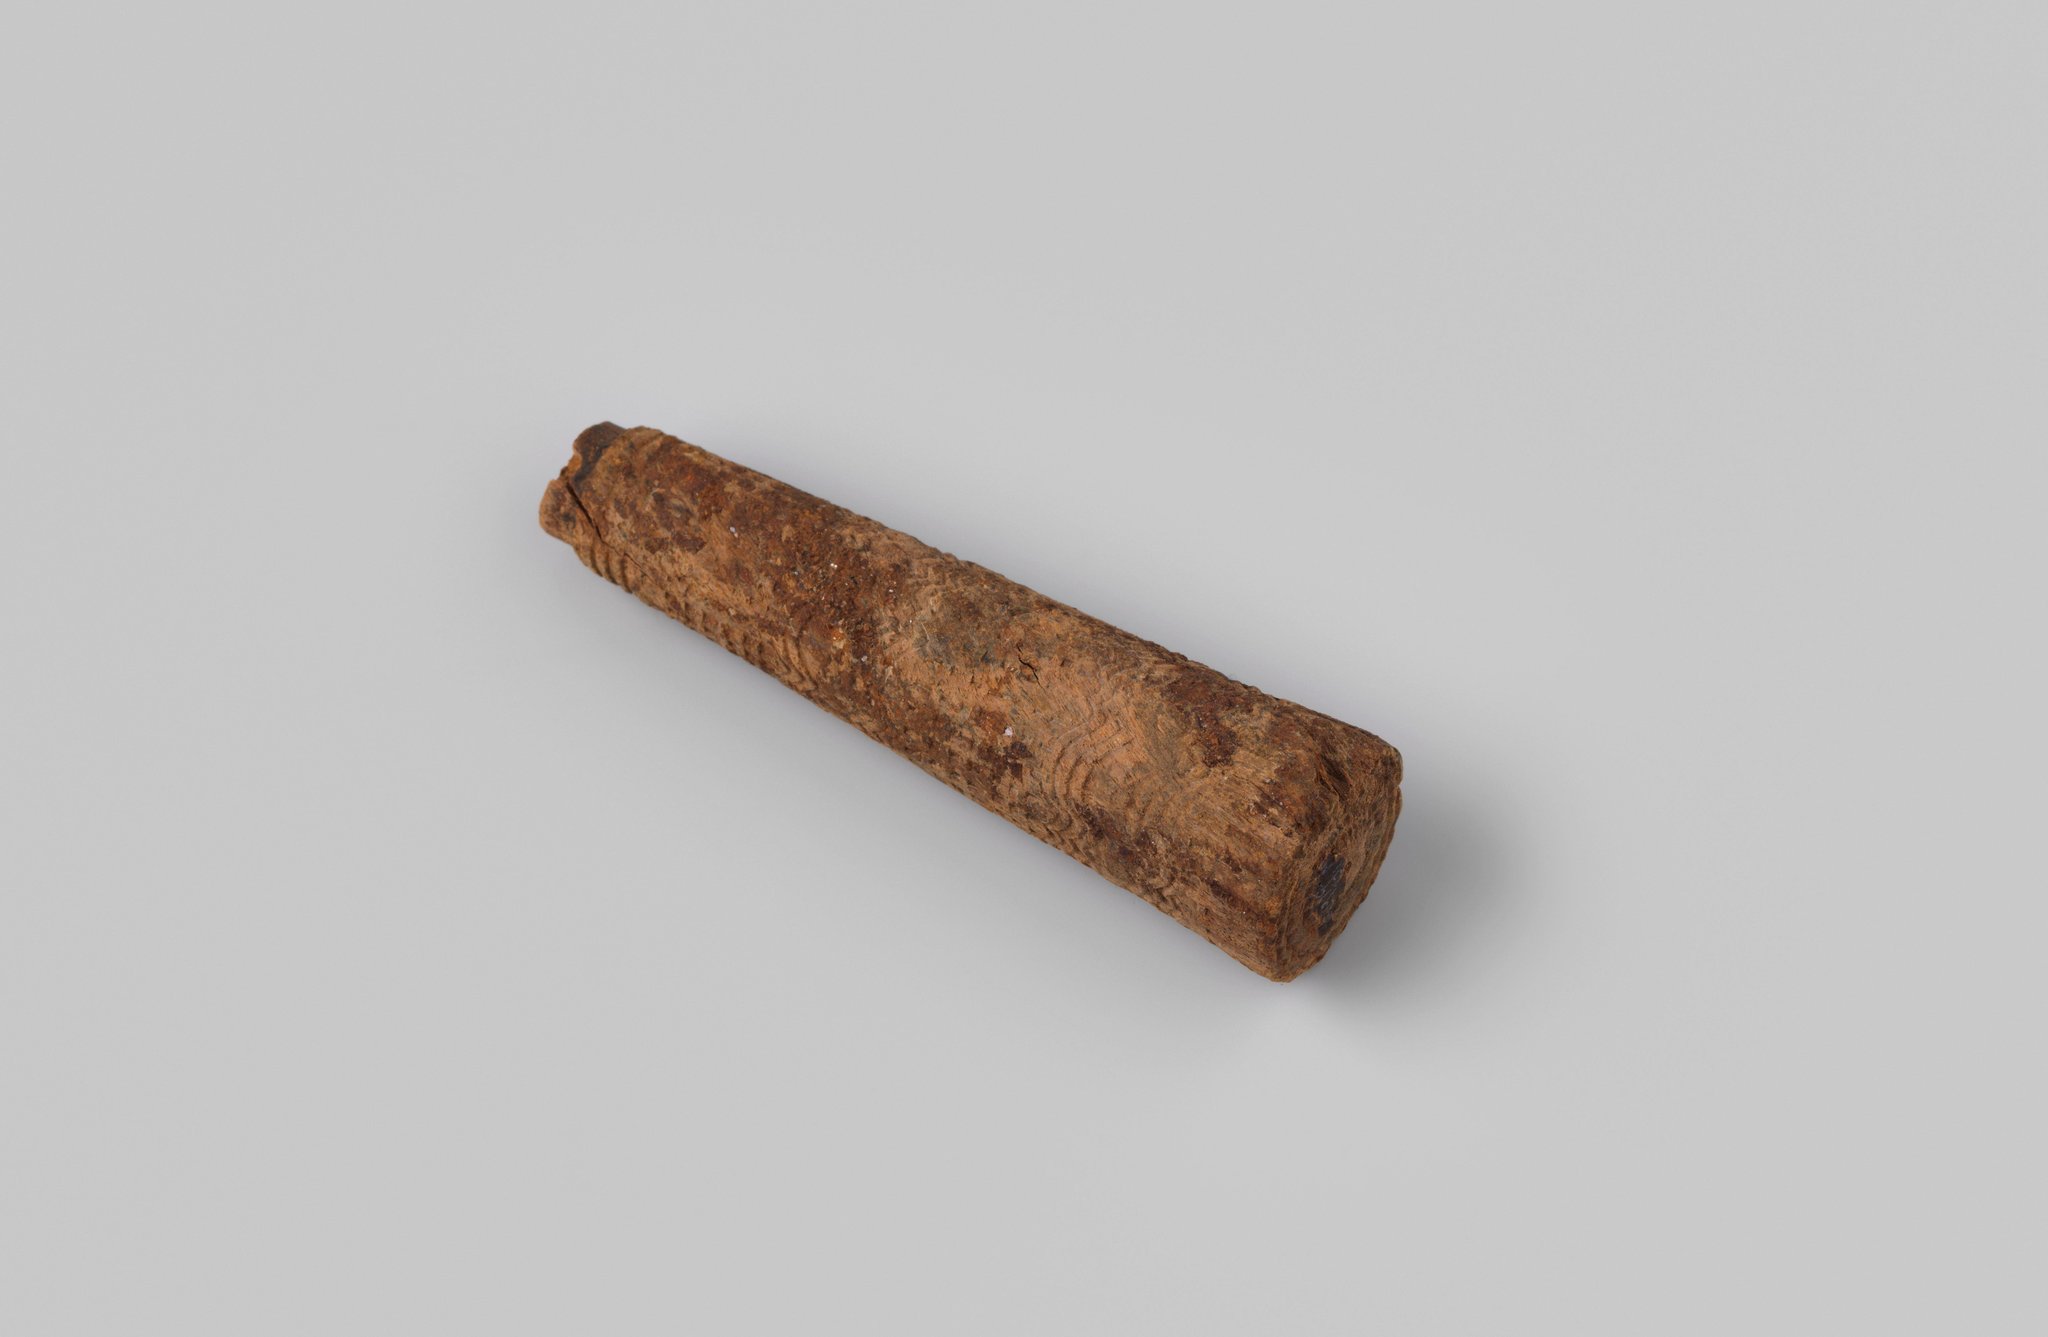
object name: knife handle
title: Messenheft uit het wrak van de Oost-Indiëvaarder Hollandia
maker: Anonymous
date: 1700-1743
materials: wood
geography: netherlands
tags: verenigde oostindische compagnie, hollandia (schip), annet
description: Knife, handle, cylindrical: tapering; id. NG 1979-403H, ferrules id. NG 1980-27H426.